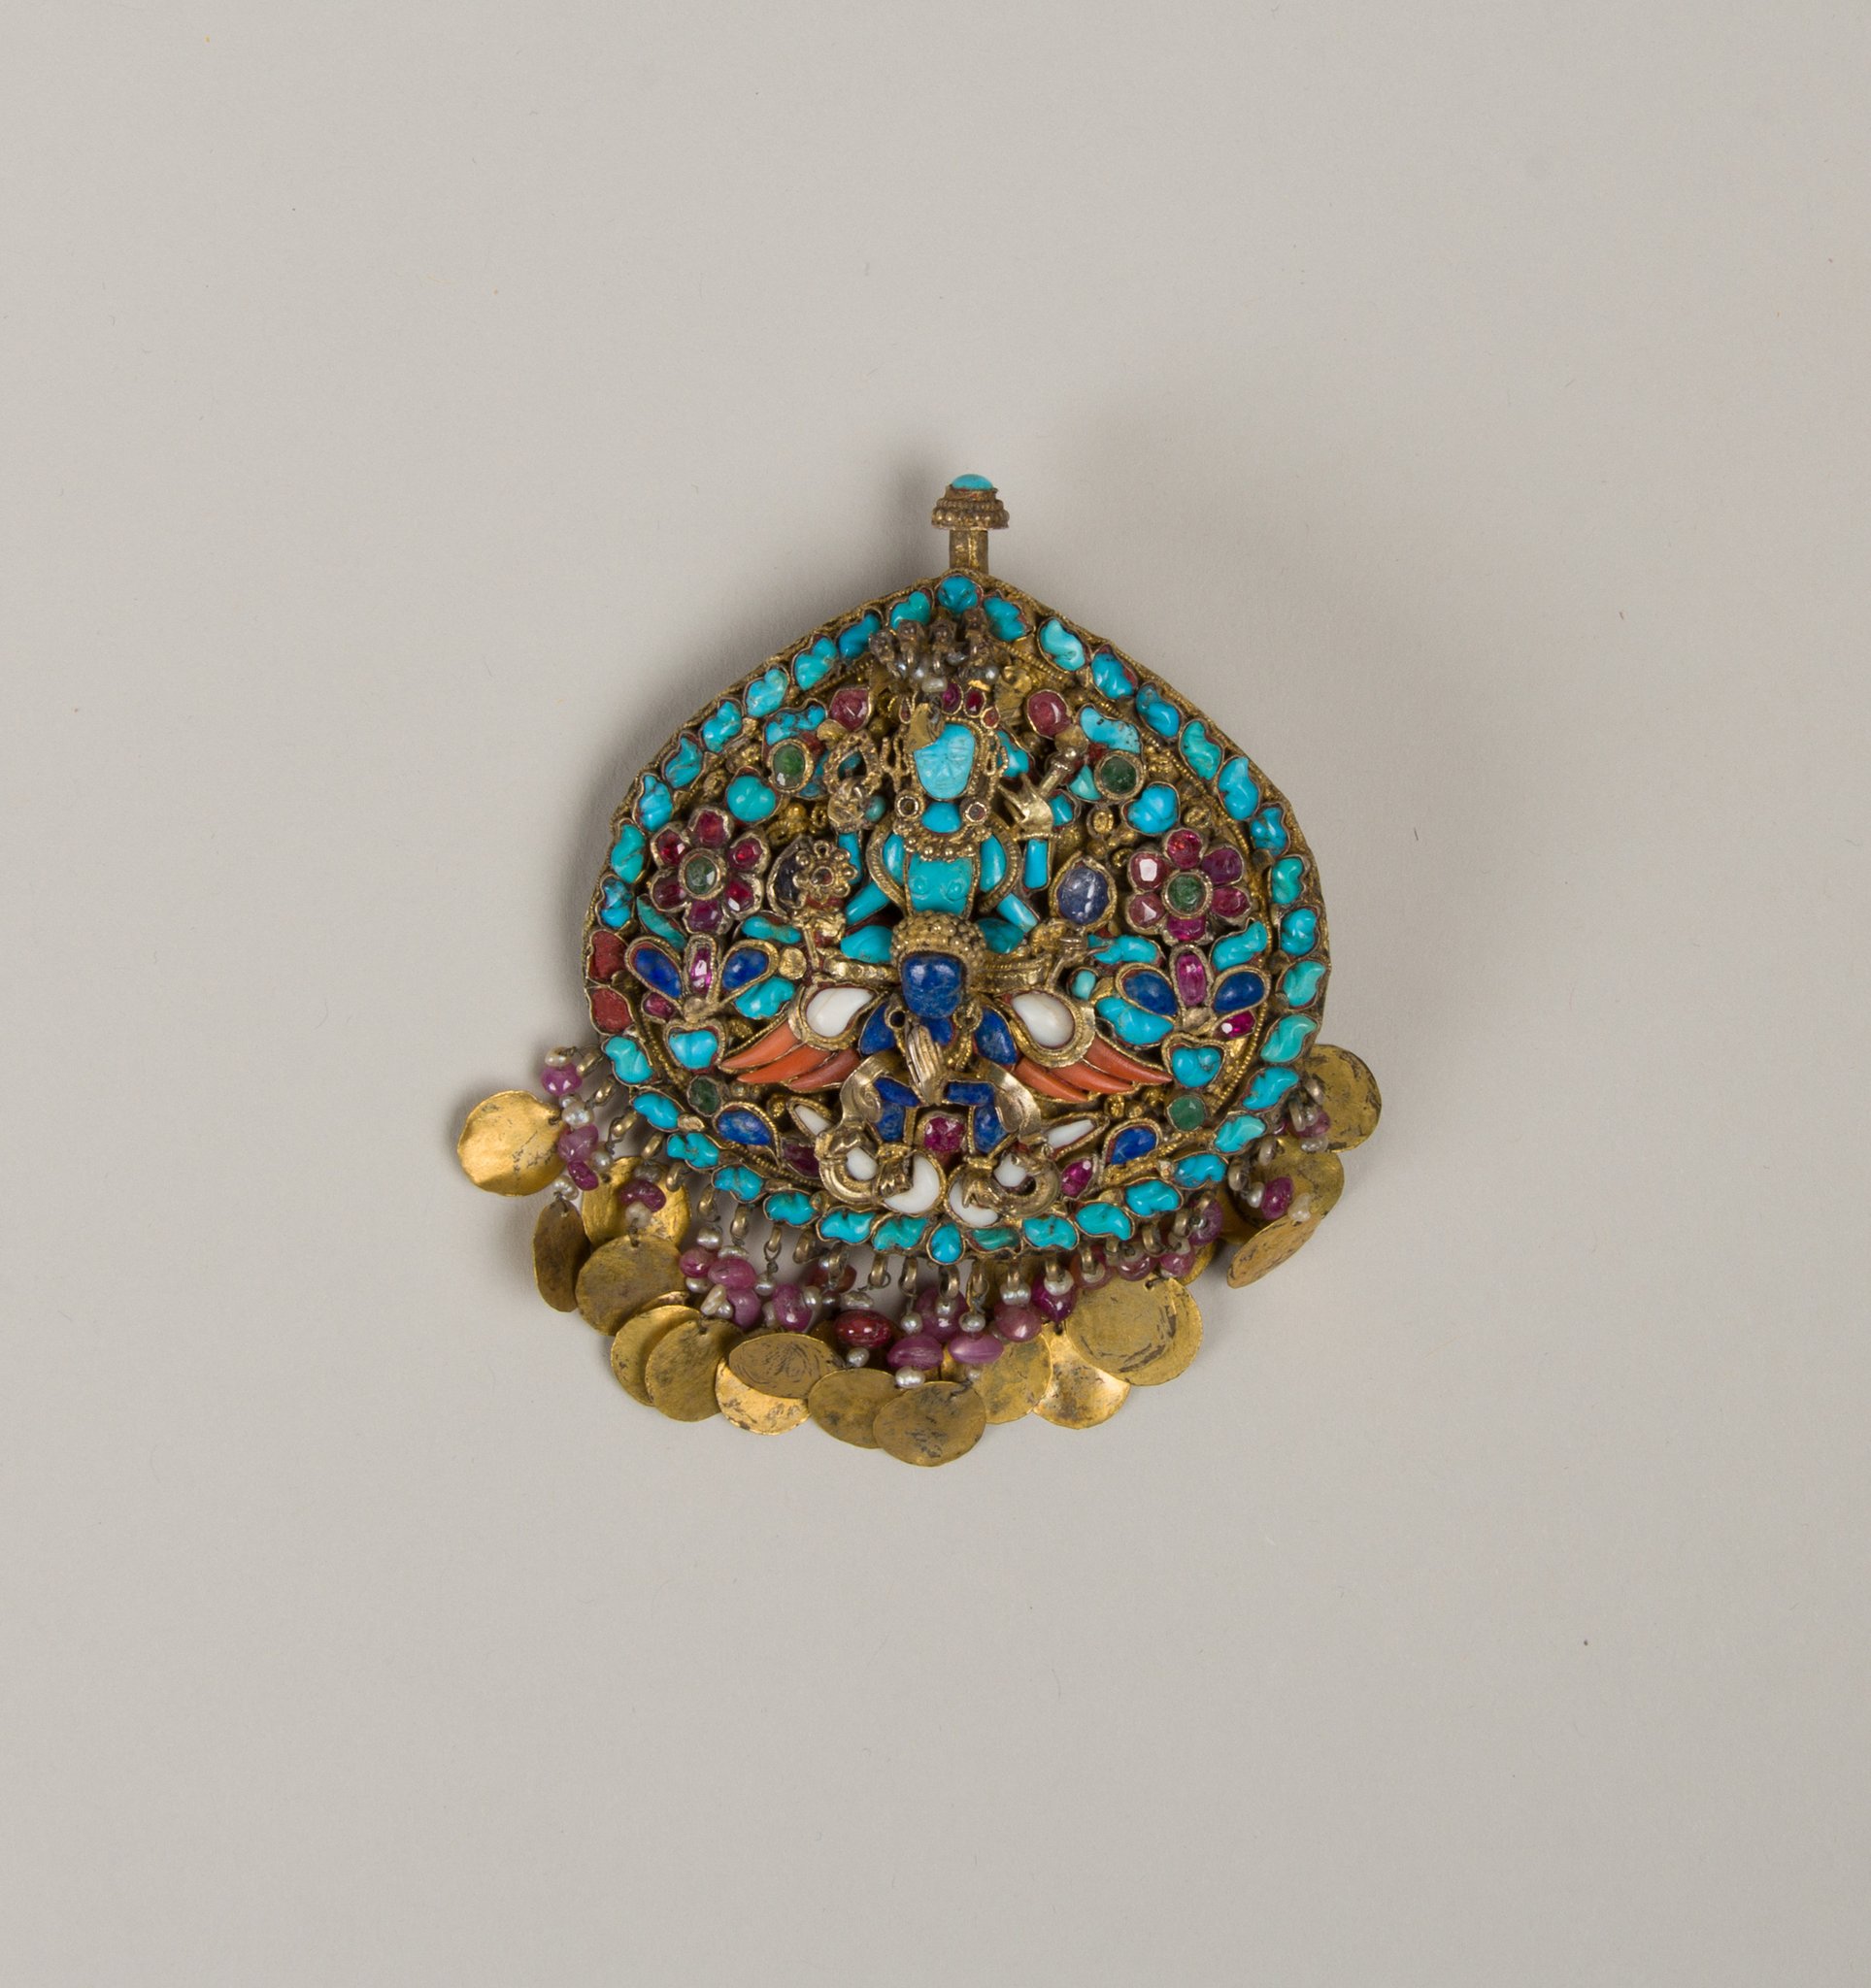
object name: ornament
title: Earring for a Deity Showing Vishnu Riding Garuda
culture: nepali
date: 1601-1900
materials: coral, silver gilt, lapis lazuli, pearl, gemstone, shell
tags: mythical creatures,vishnu